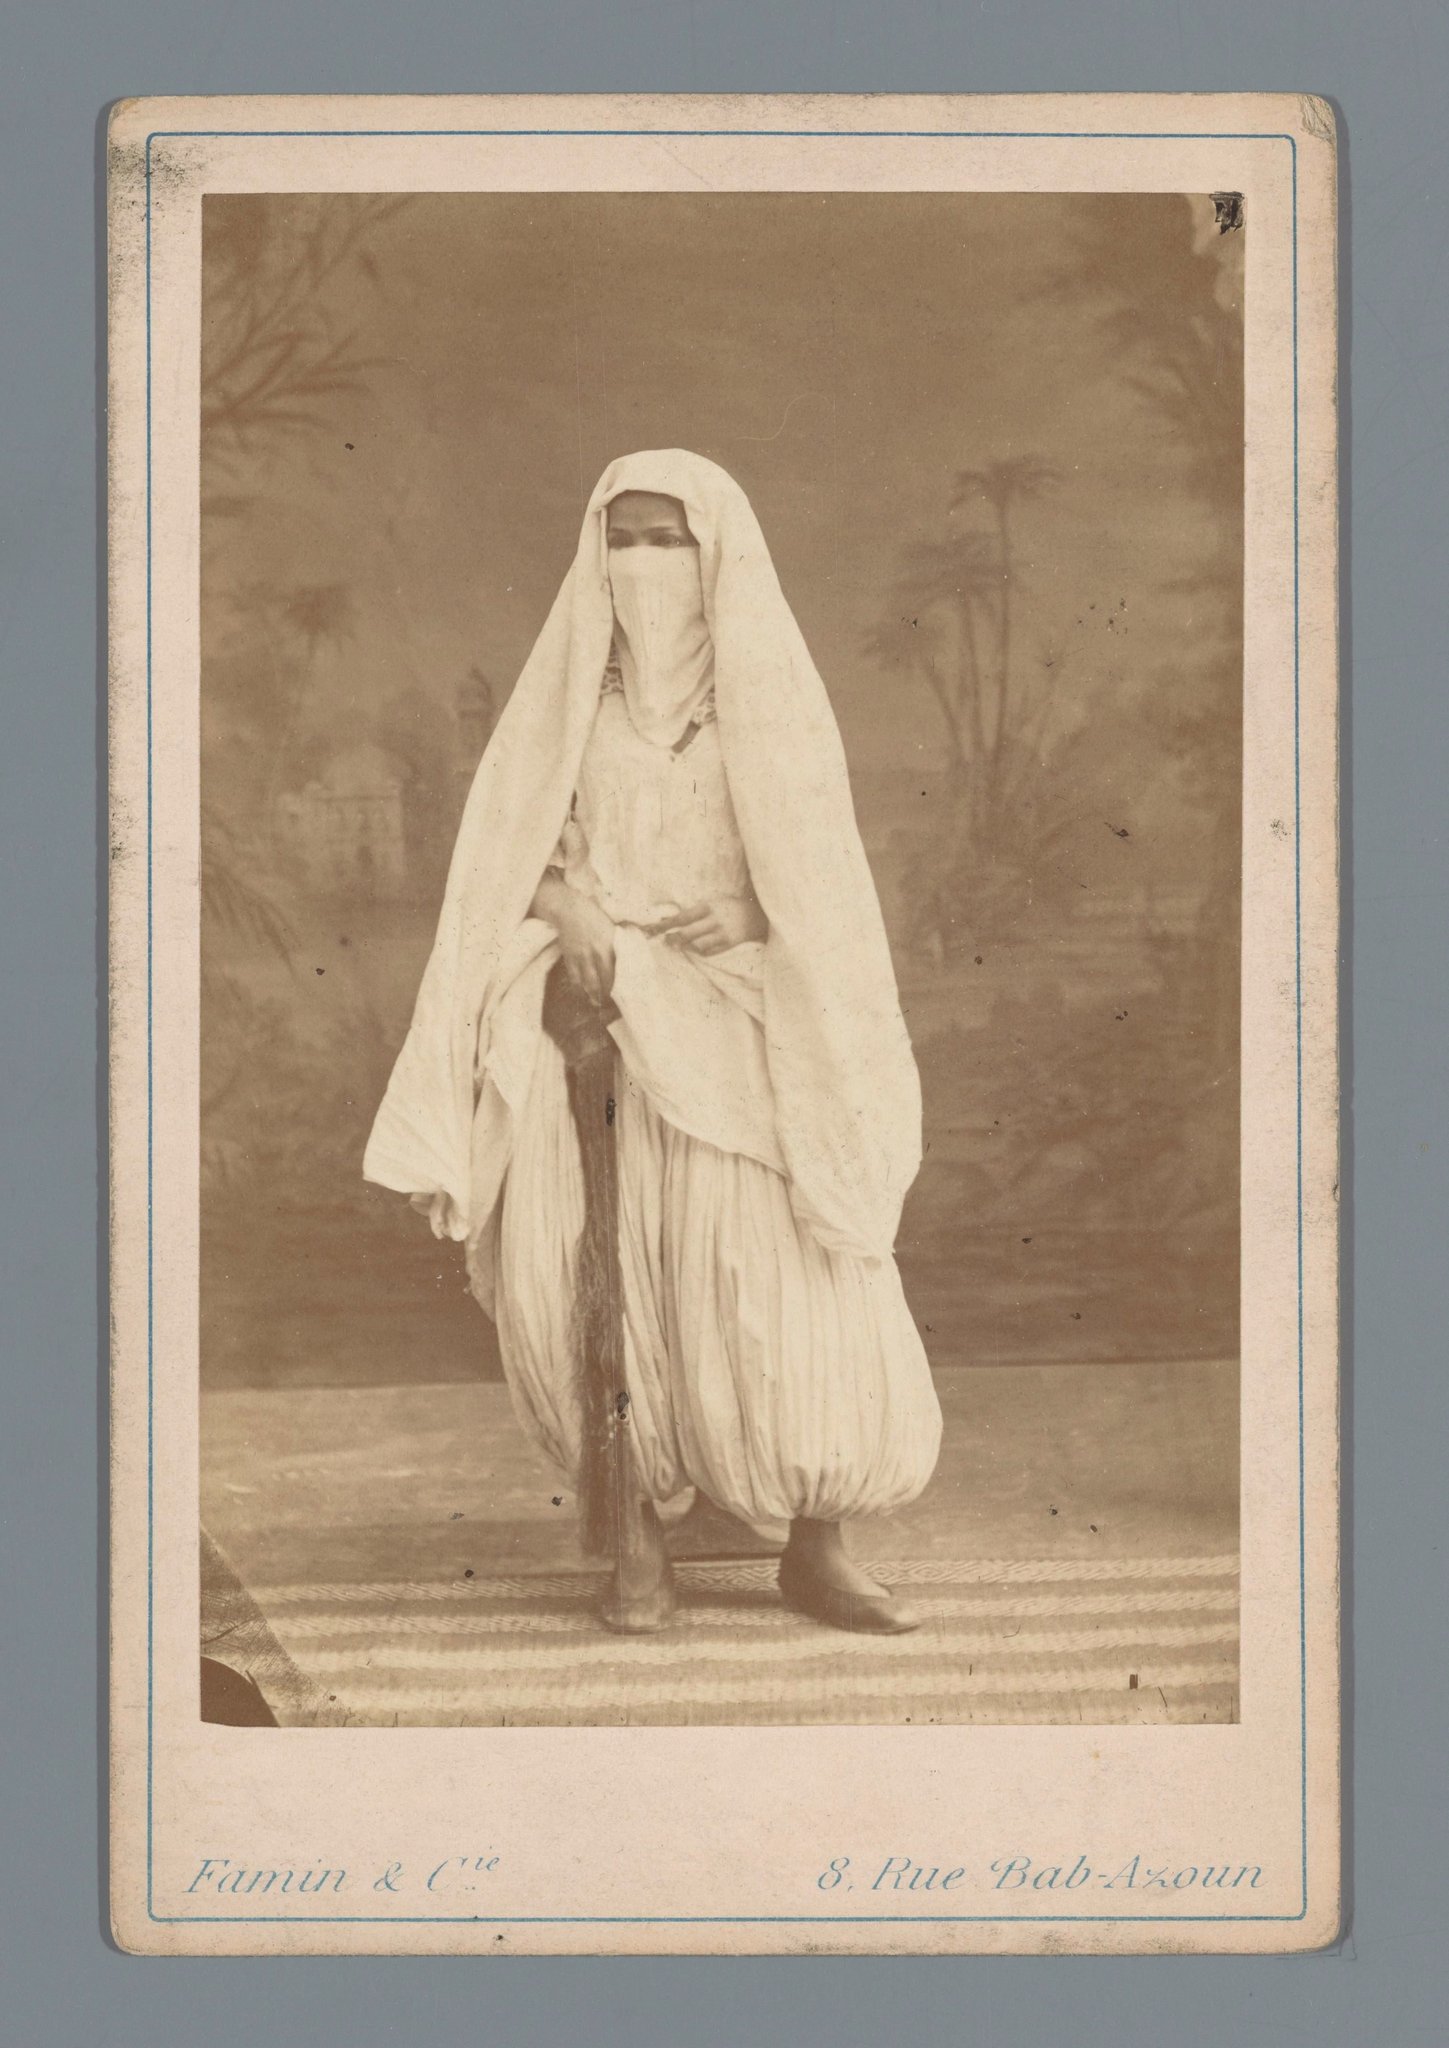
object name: cabinet photograph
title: Algerijnse vrouw in harembroek en sluier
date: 1863-1889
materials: cardboard, photographic support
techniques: albumen print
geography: algeria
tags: veil, anonymous historical person portrayed - bb - woman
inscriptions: inscription: ‘Alger/ 8, Rue Bab-Azoun, 8.’, inscription: ‘8, Rue Bab-Azoun’